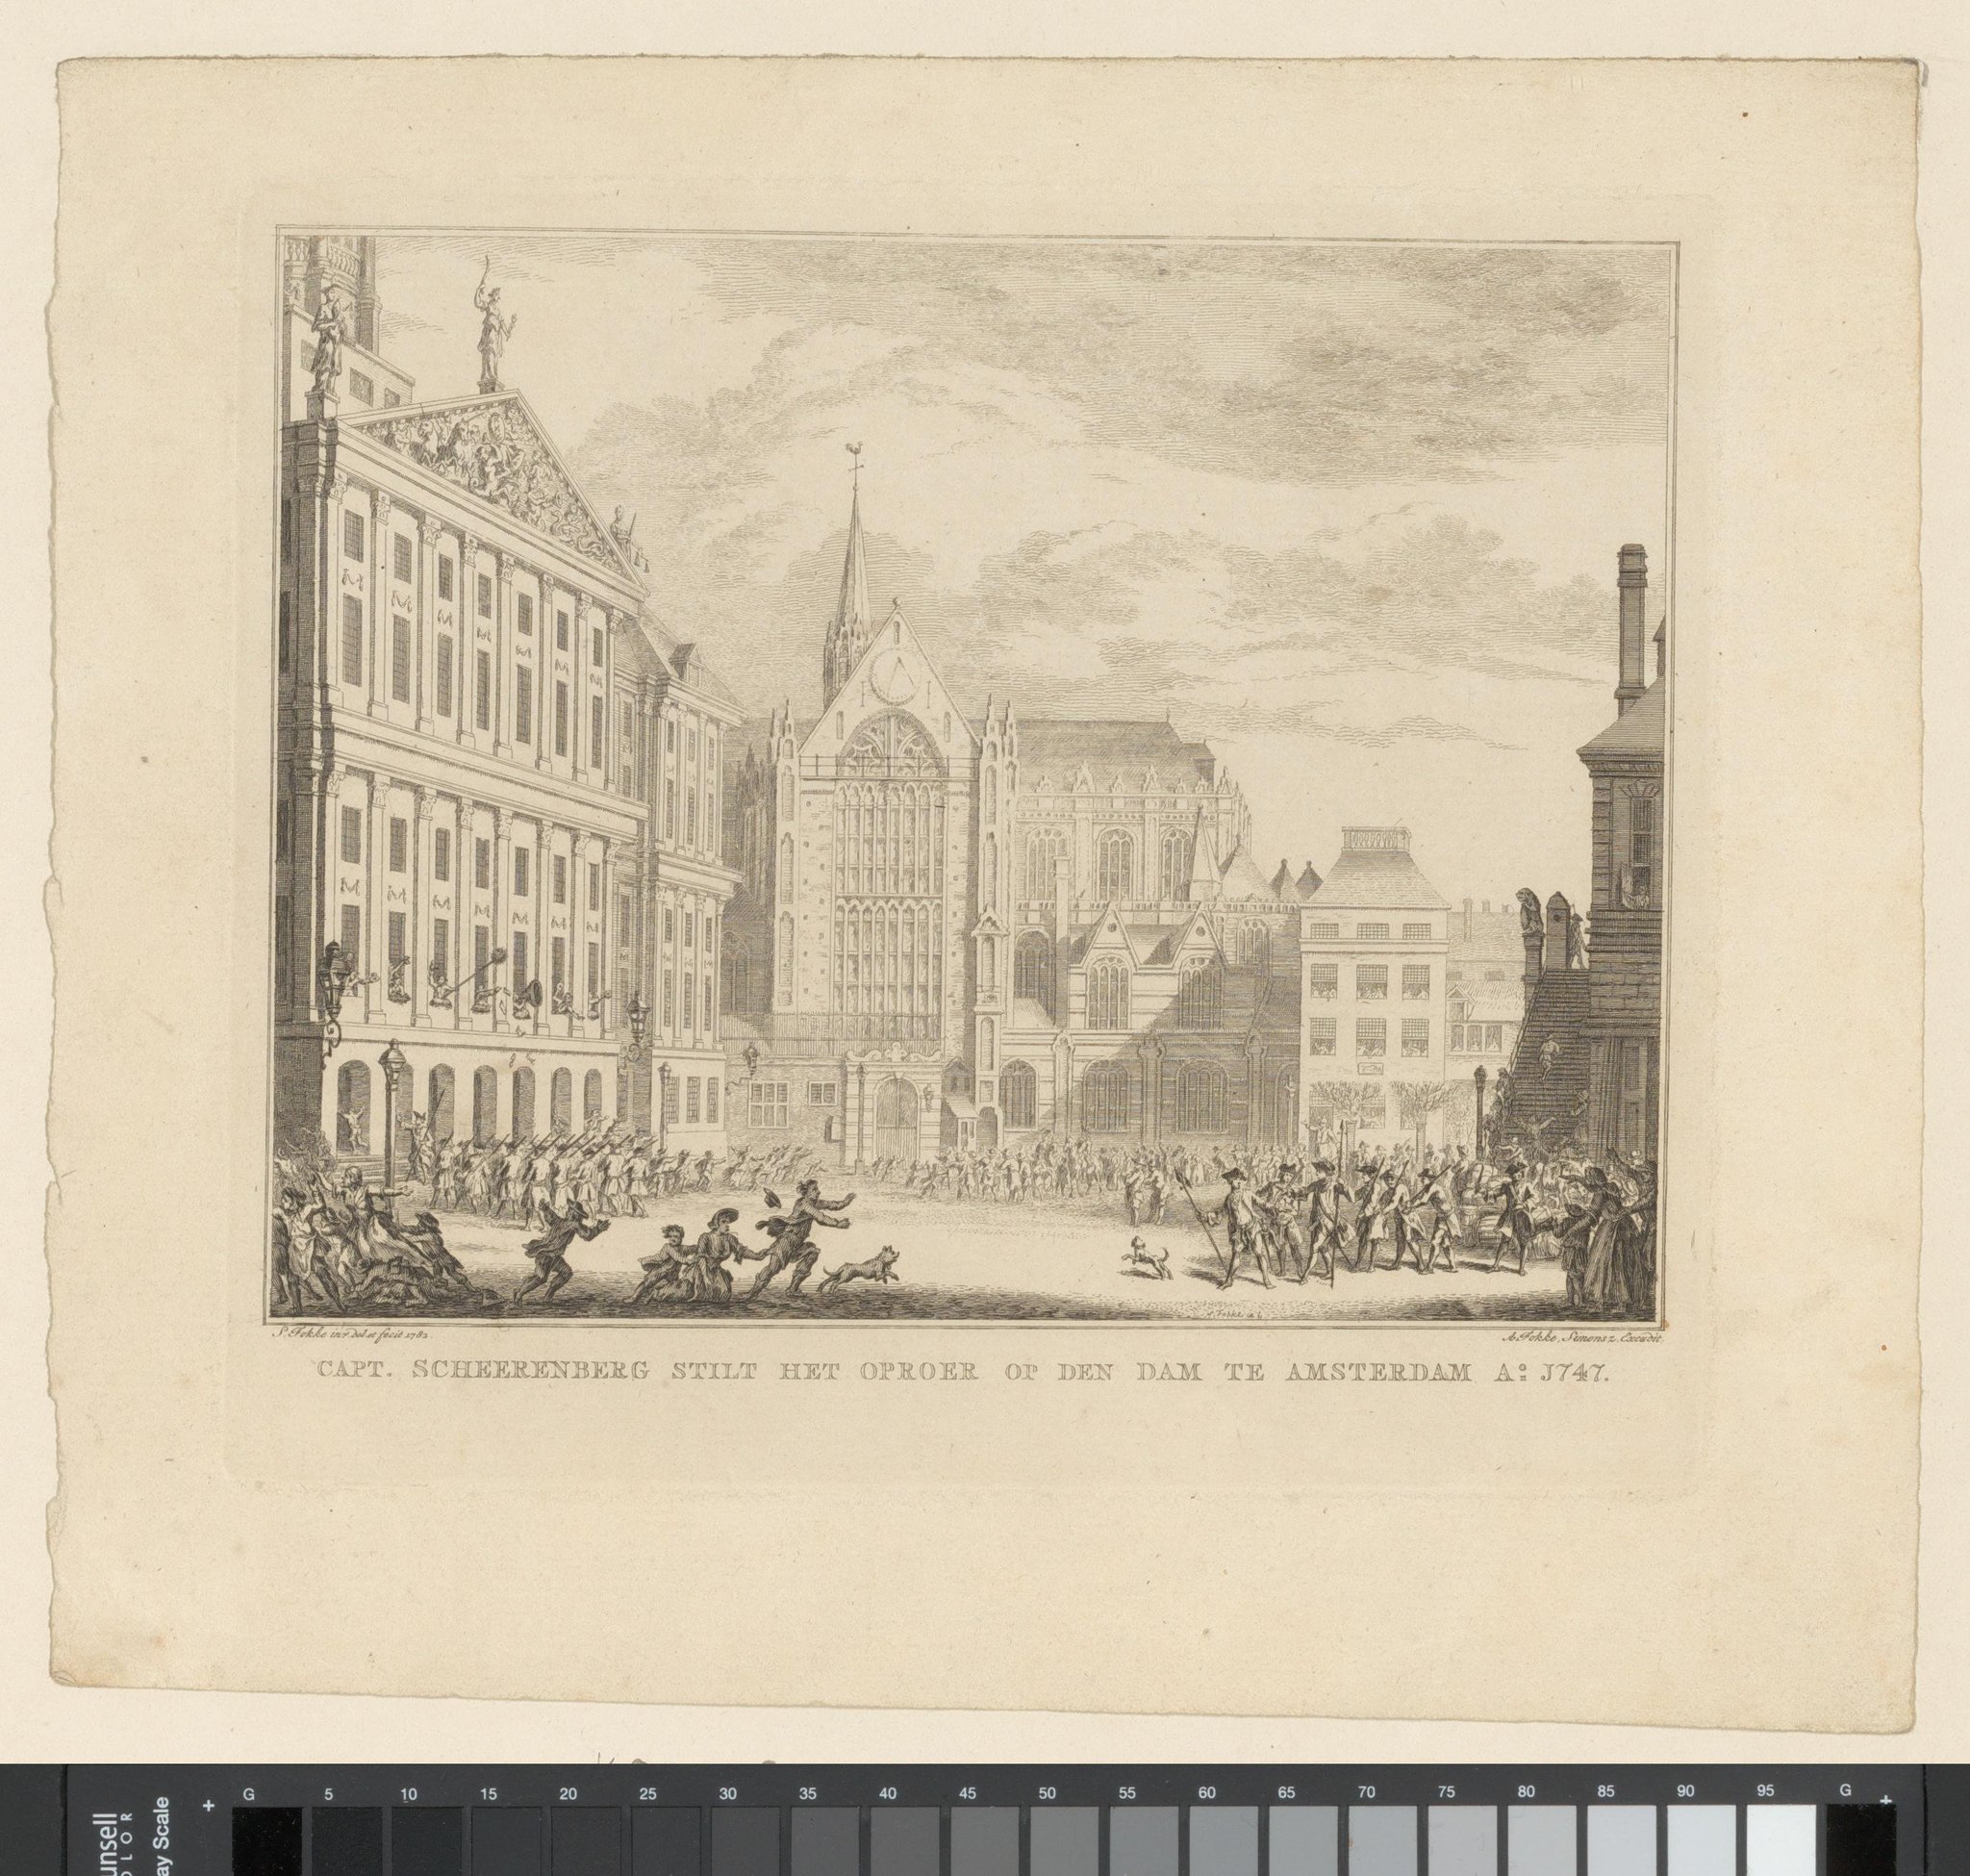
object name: print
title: Capt. Scheerenberg stilt het oproer op den Dam te Amsterdam ao. 1747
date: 1782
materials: paper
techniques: engraving, etching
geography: amsterdam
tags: amsterdam, church (exterior), townhall, street-fights, riots, strike (political demonstration)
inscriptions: stamp, collector's mark: Lugt 1641, stamp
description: Onder leiding van kapitein Abraham Scheerenberg worden Oranjegezinde oproerkraaiers, aangevoerd door Daniël Raap, verjaagd uit het stadhuis en van de Dam op 9 november 1747. In het bezette stadhuis steekt een demonstrant een ragebol uit het raam, wat een spottende verwijzing is naar de door de schout gedragen roede. In het midden de Nieuwe Kerk en rechts een deel van de Waag. Onderwerpsrubrieken binnen de Atlas Zeden en Gewoonten: Krijgswezen, Schutterij, Historieprenten.